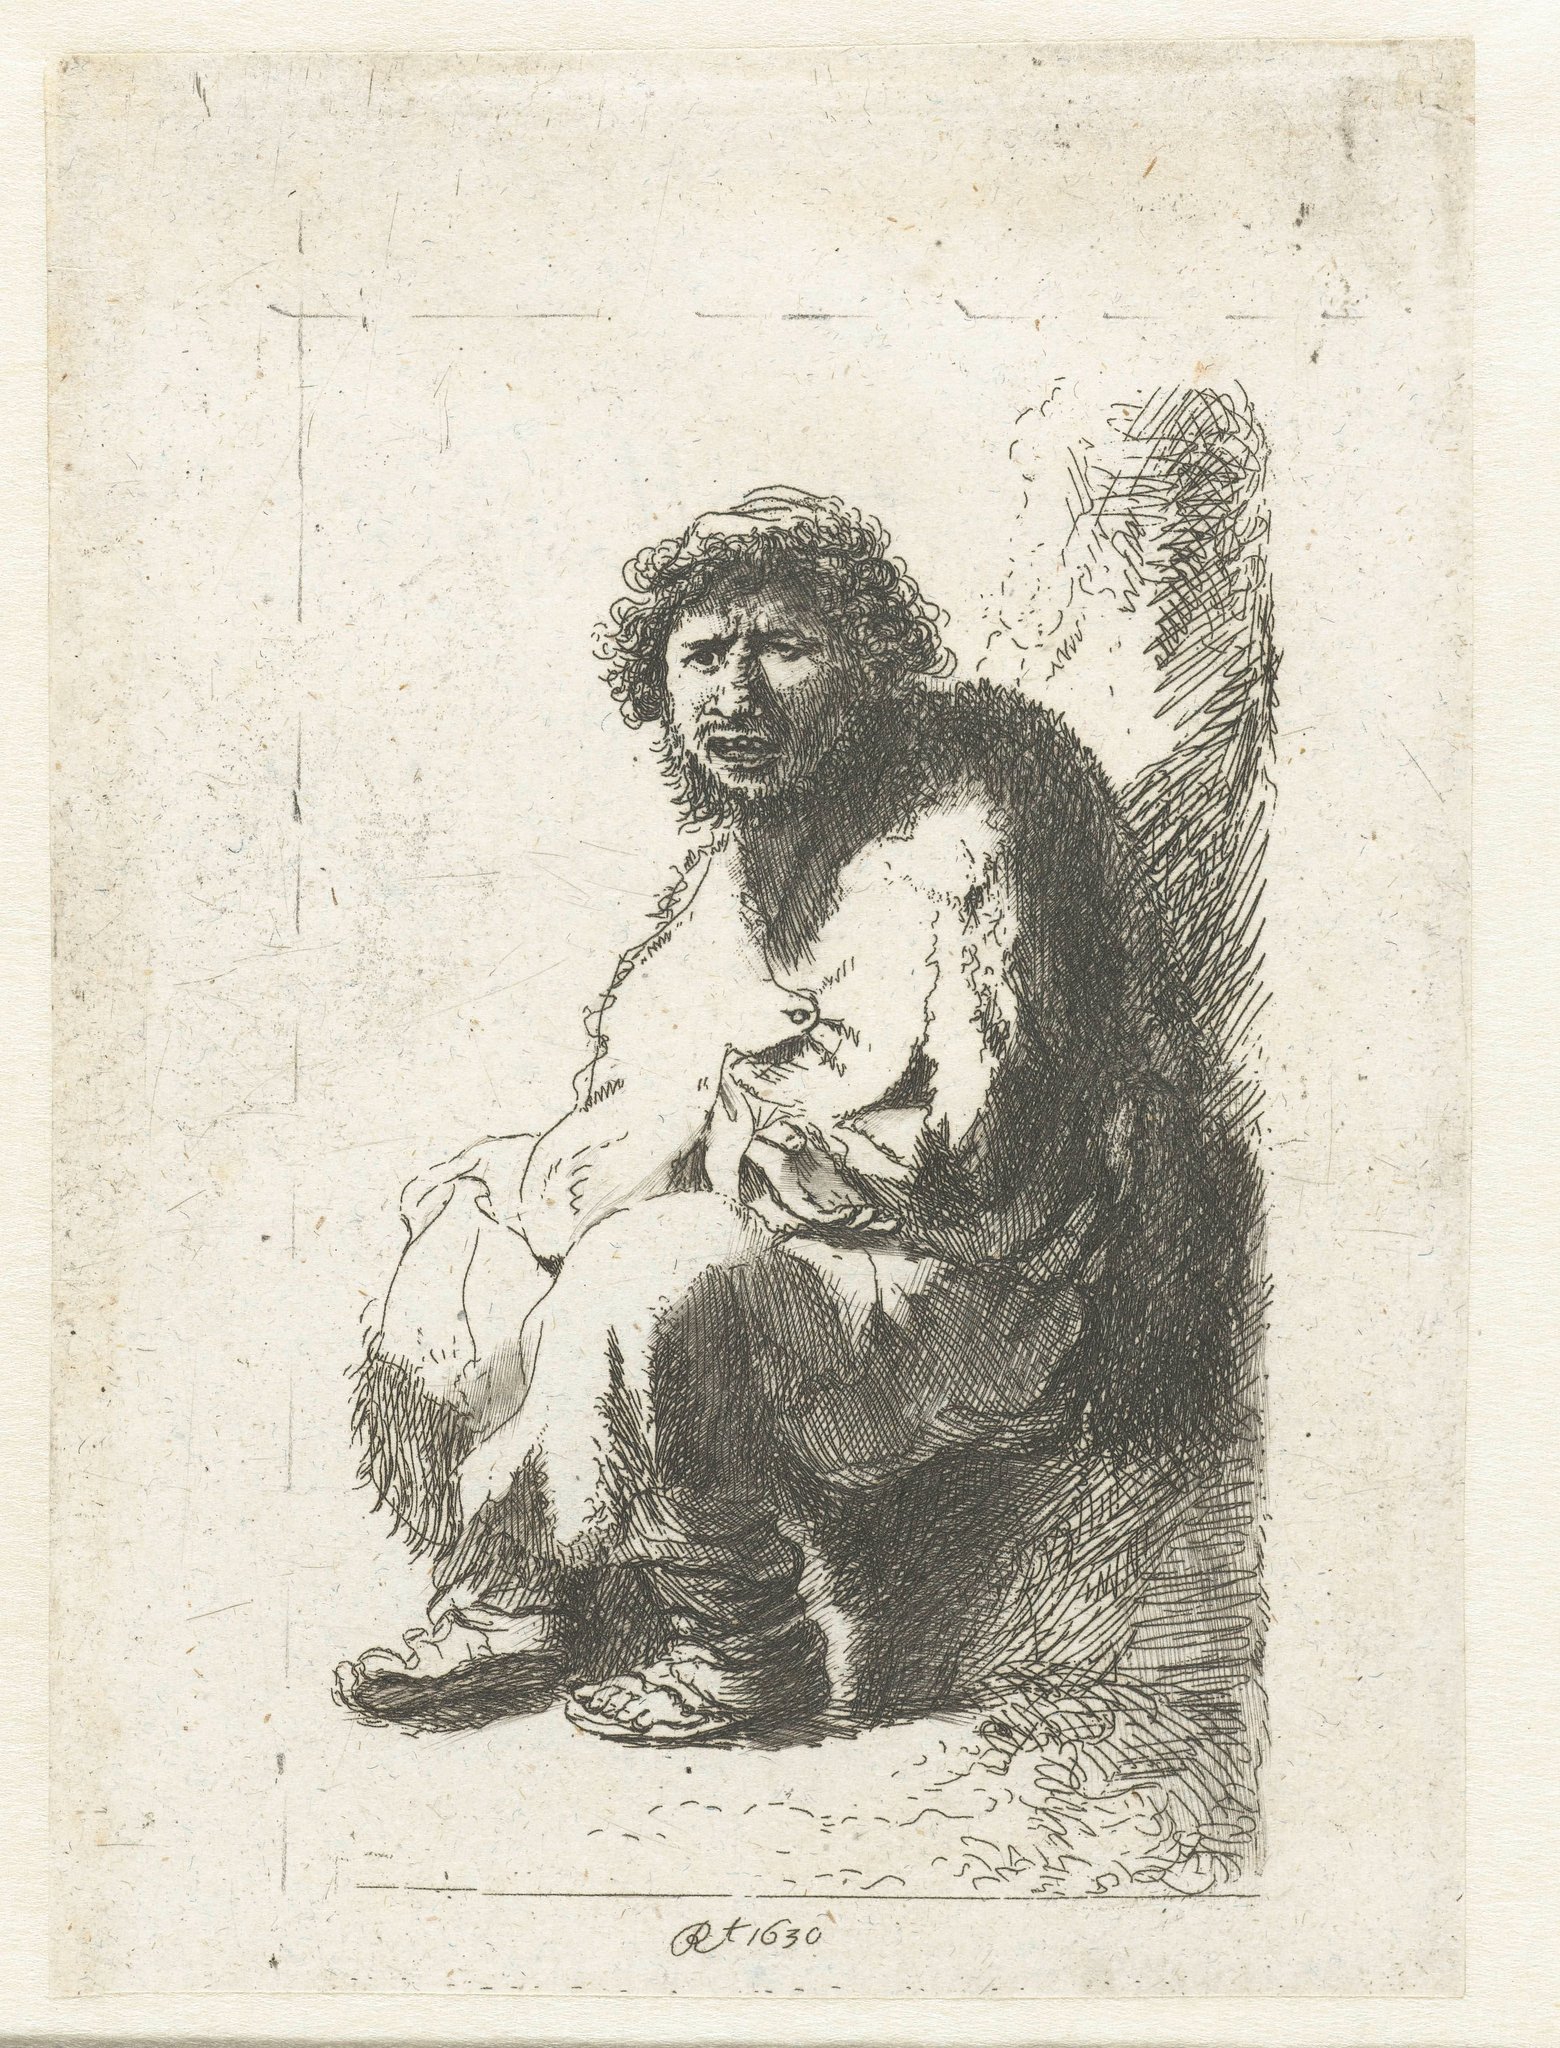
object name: print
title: Beggar seated on a bank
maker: Anonymous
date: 1630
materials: paper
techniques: etching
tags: beggar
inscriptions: collector's mark: Lugt 2228, collector's mark: Lugt 2760